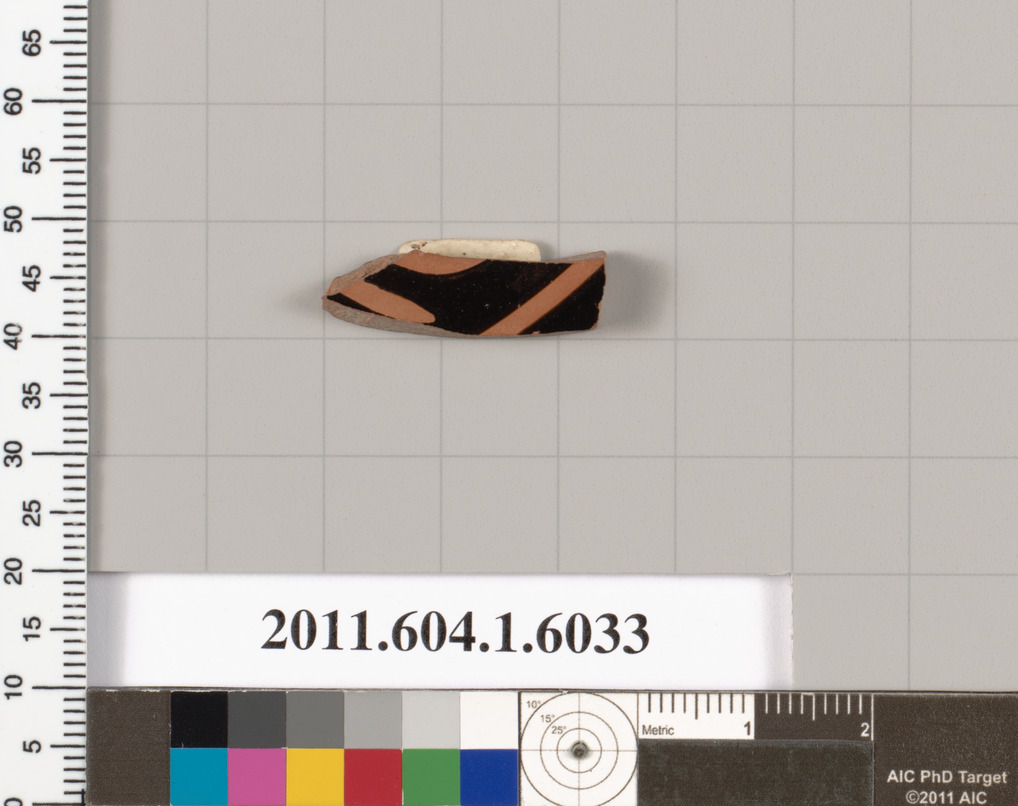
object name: kylix fragment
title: Terracotta fragment of a kylix (drinking cup)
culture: greek, attic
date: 510-500 BCE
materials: terracotta